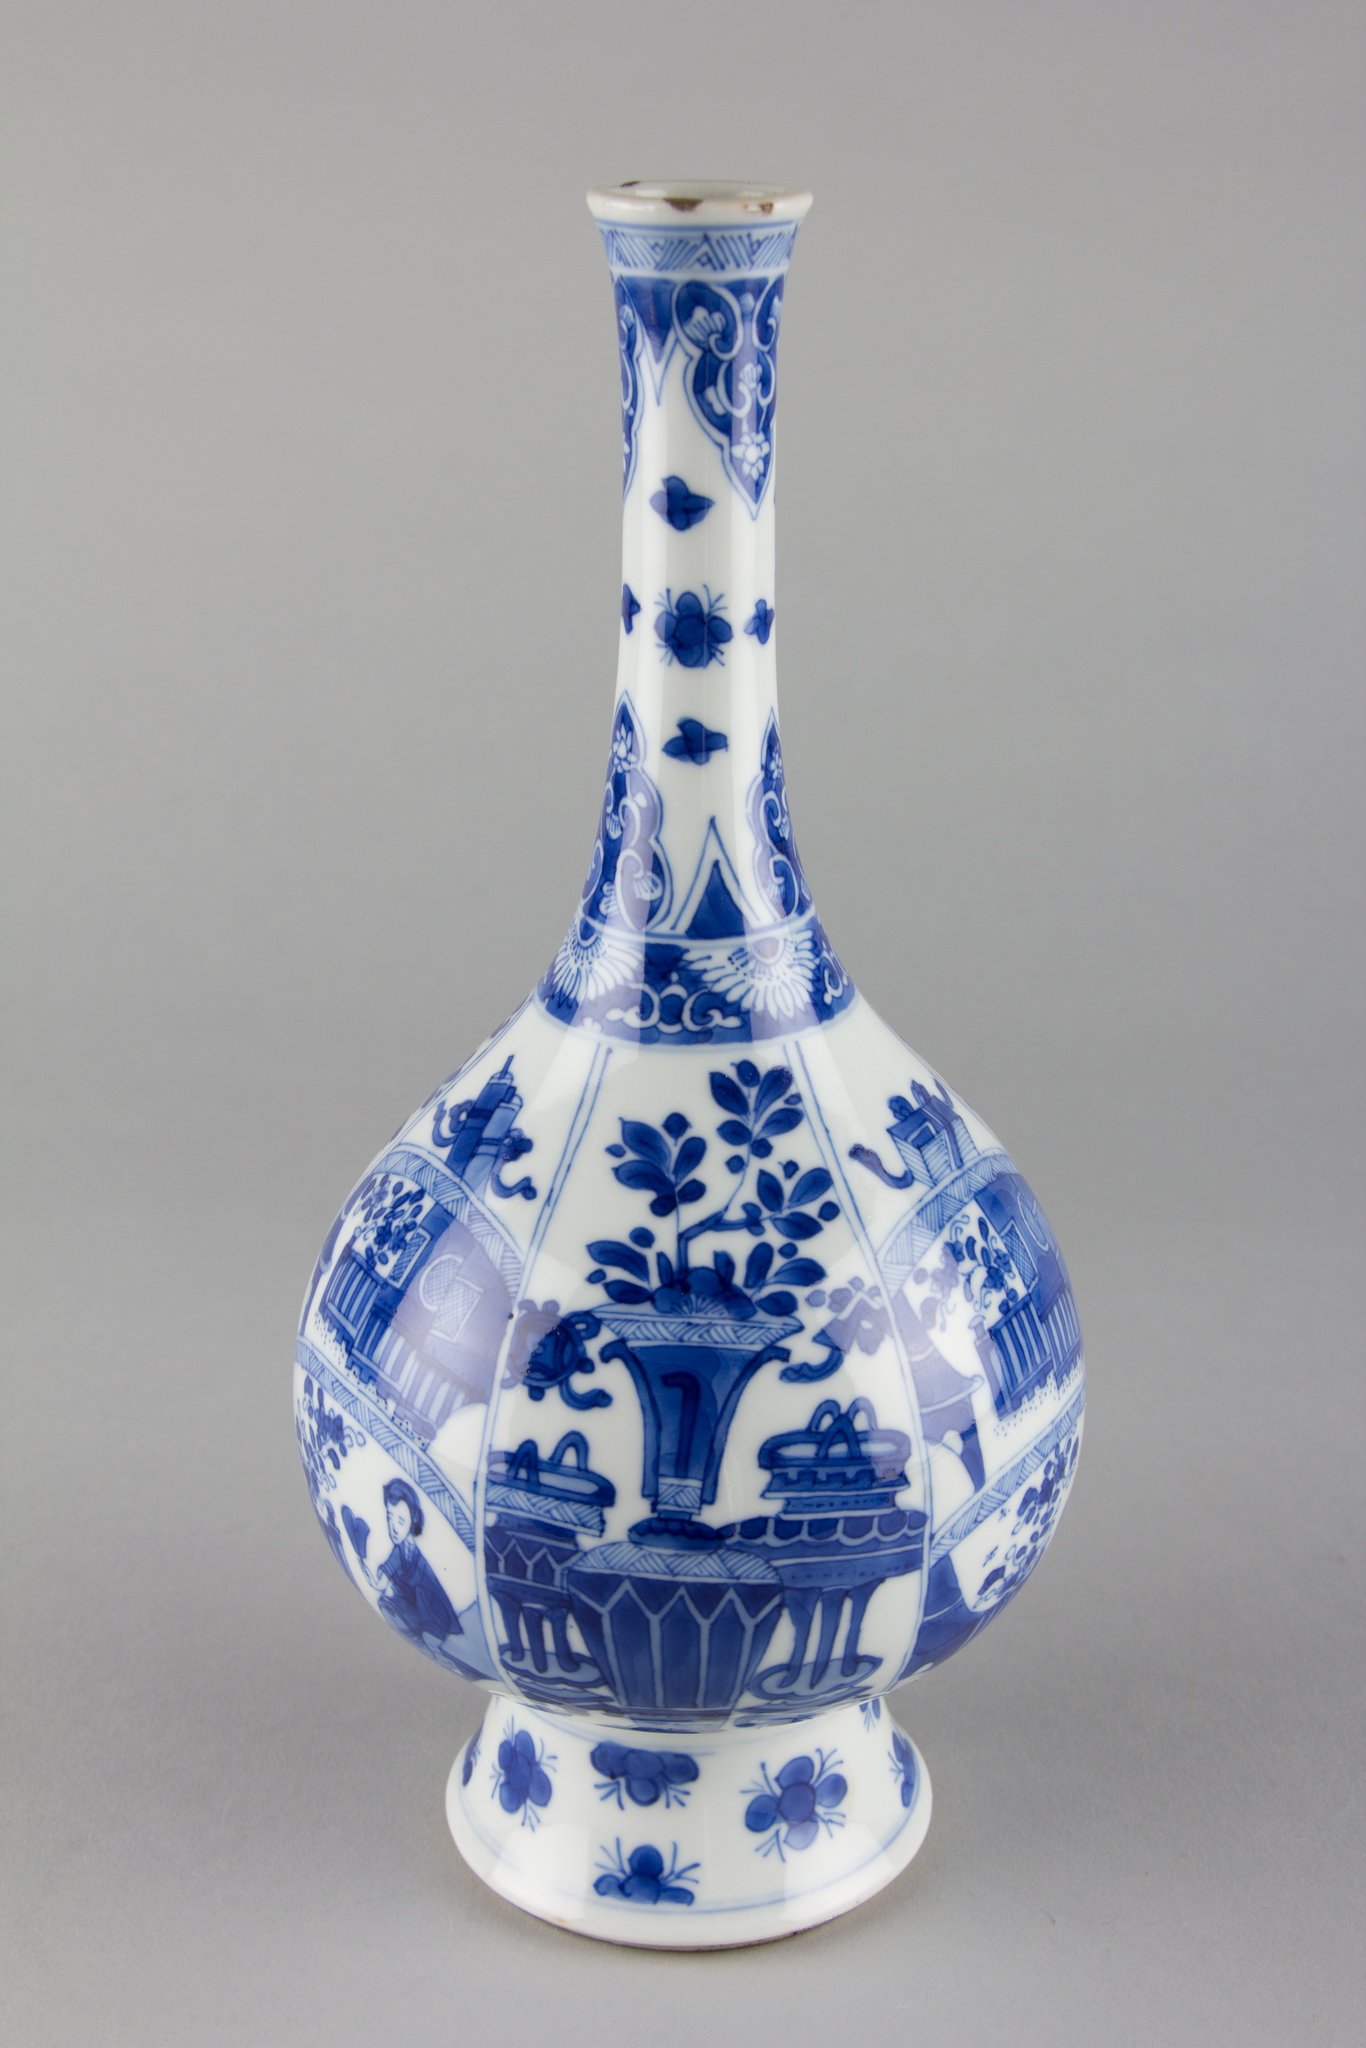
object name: vase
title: Vase with ladies and flowers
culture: chinese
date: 1667-1733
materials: cobalt, porcelain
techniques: painting, underglaze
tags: plants